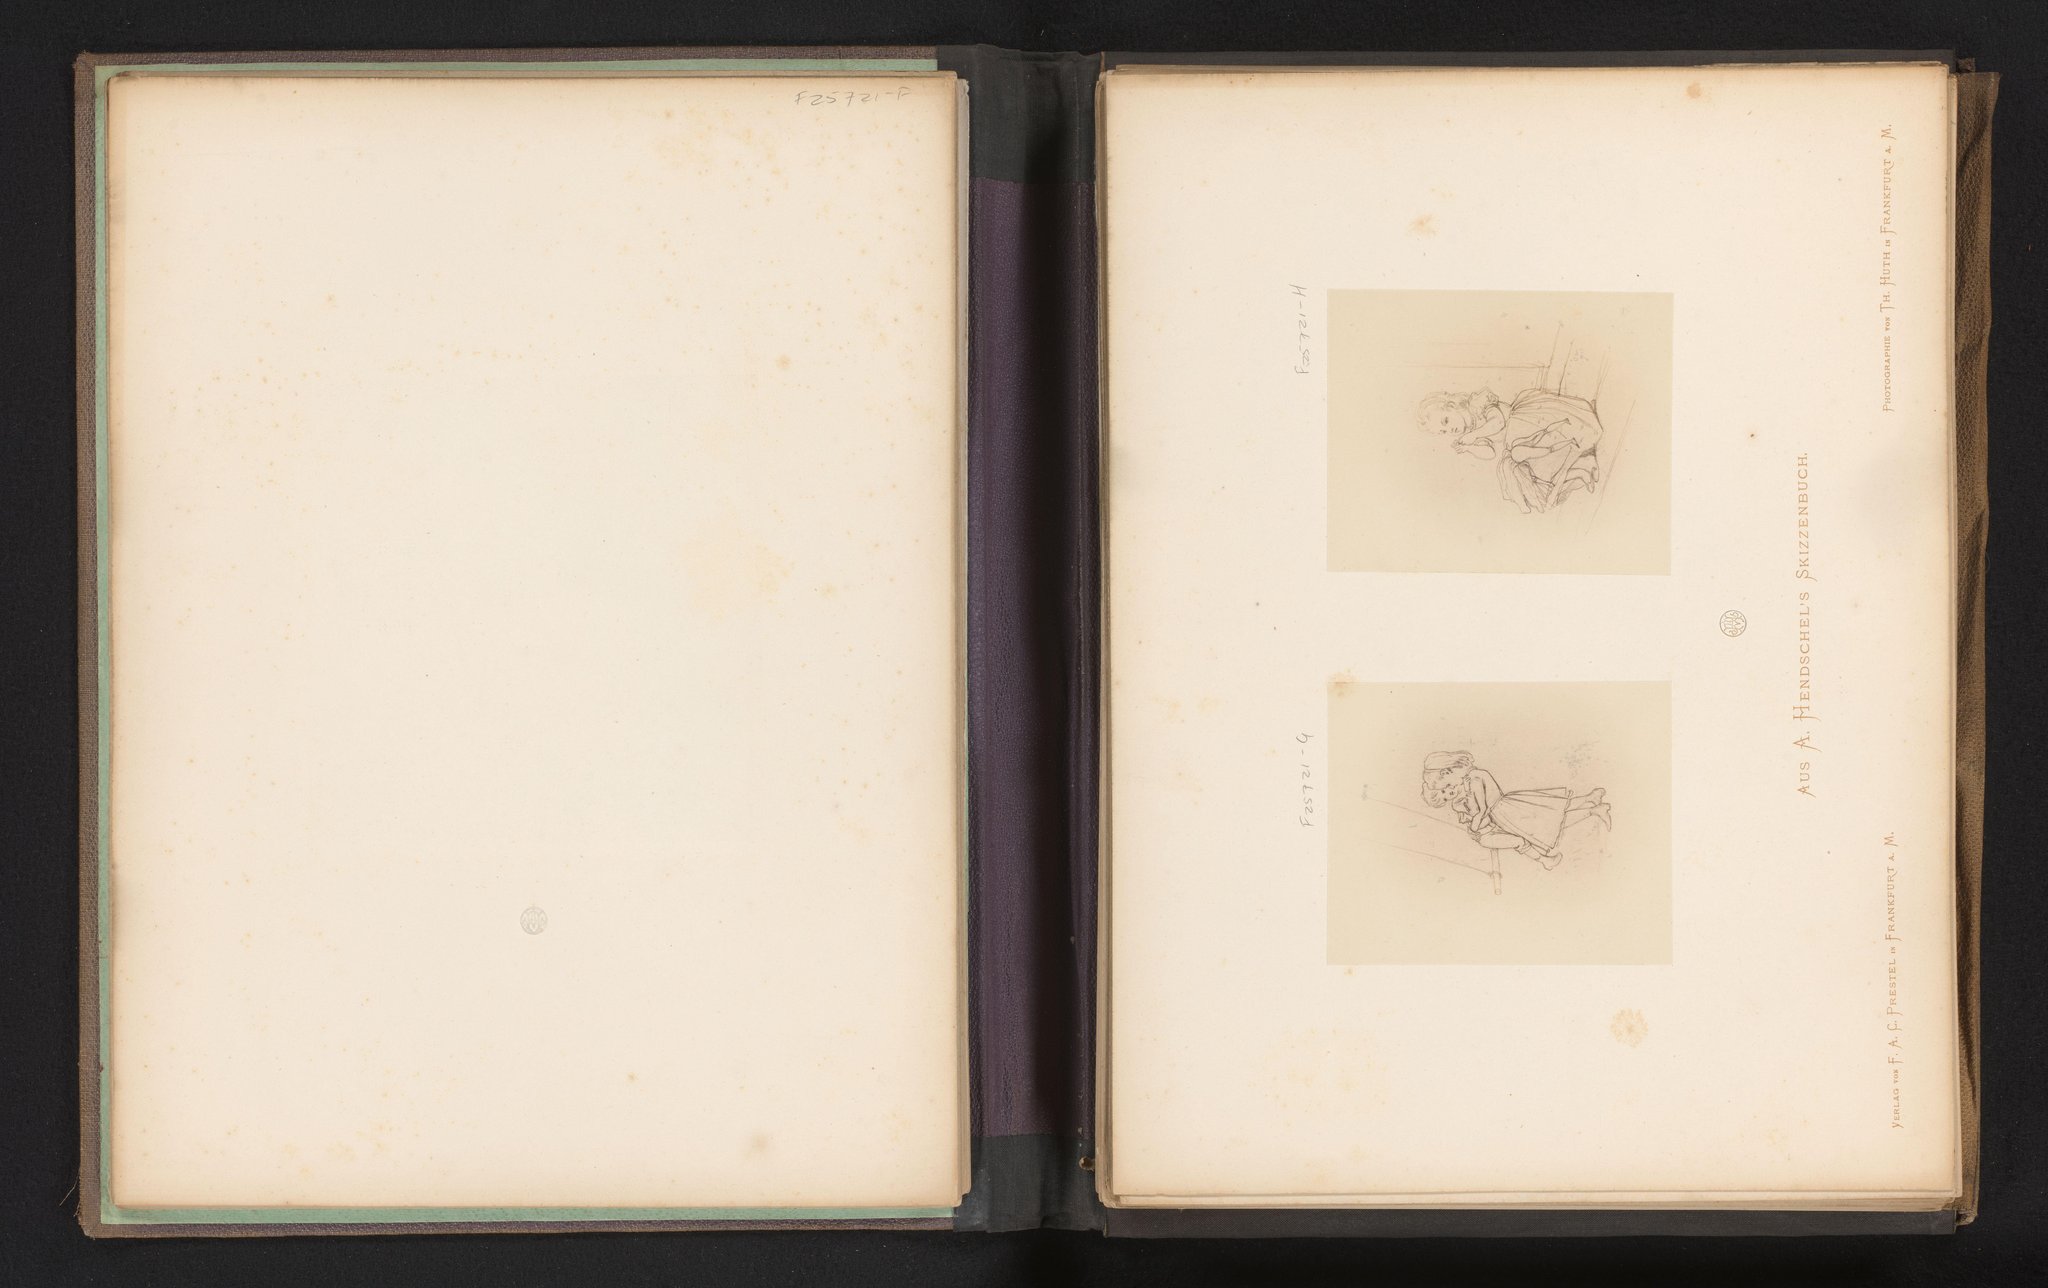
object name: reproduction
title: Aus A. Hendschel's Skizzenbuch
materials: paper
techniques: albumen print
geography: frankfurt am main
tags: girl (child between toddler and youth)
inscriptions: monogram: ‘AH’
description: Deze foto maakt deel uit van een omslag met 50 foto's op 48 bladen, een lijst van afbeeldingen en een titelblad.